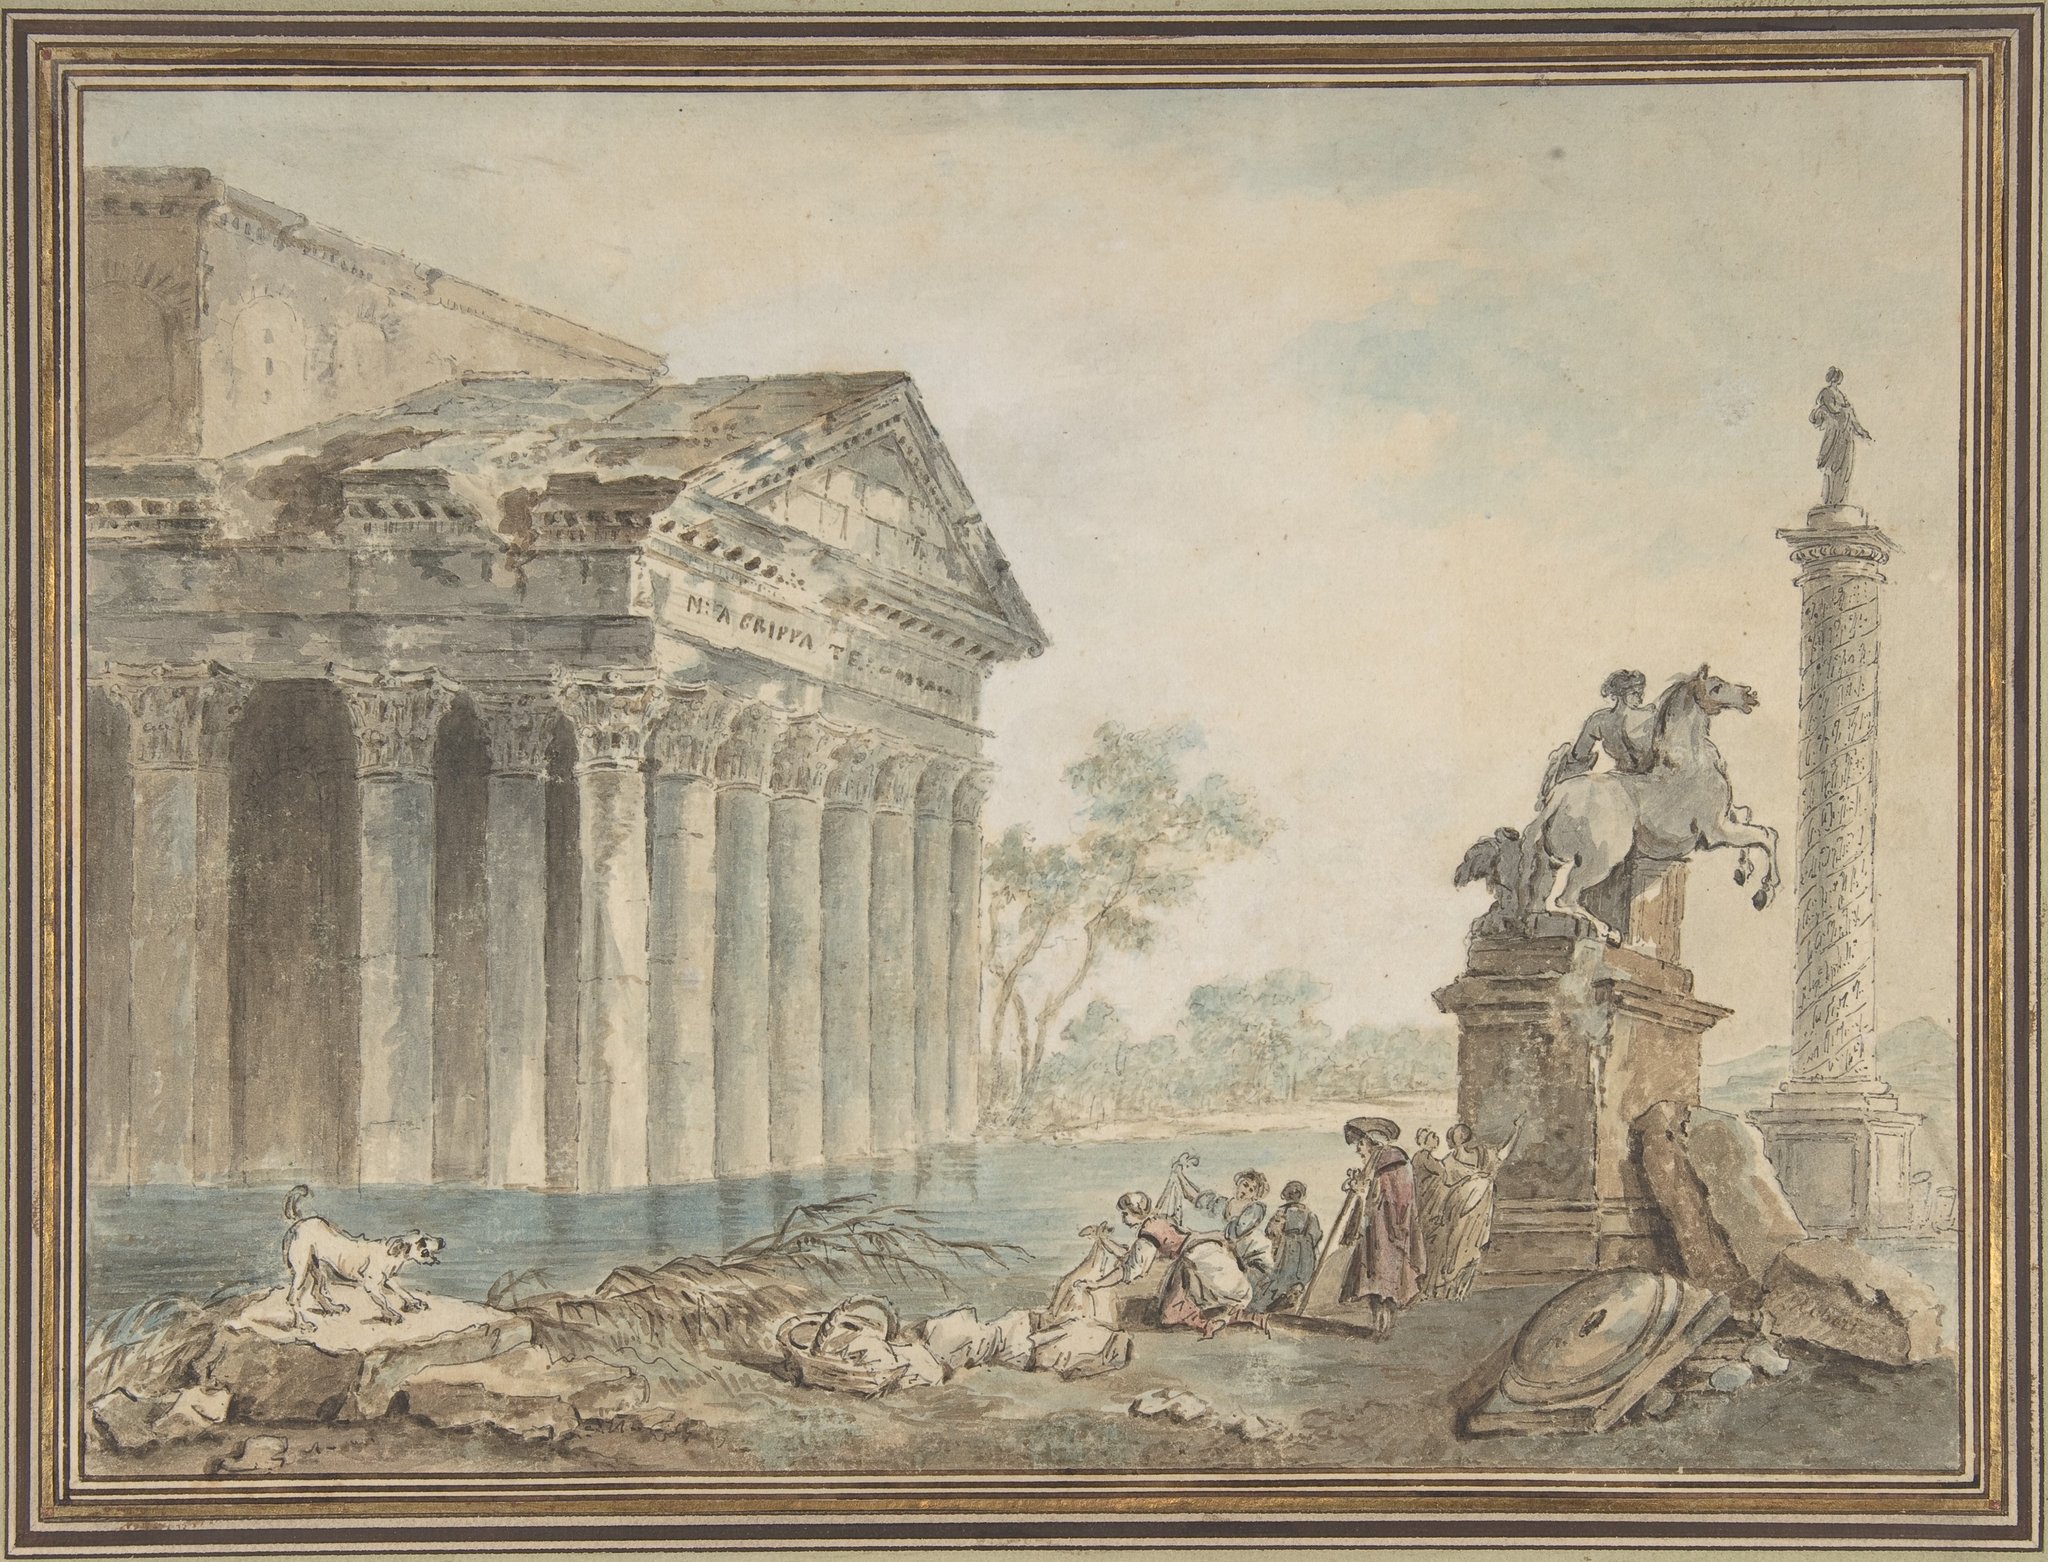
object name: drawing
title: Architectural Capriccio with Roman Monuments and Washerwomen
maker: hubert robert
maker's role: artist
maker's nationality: french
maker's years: 1733-1808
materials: ink, watercolor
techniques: brush, pen, wash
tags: monuments,ruins,women